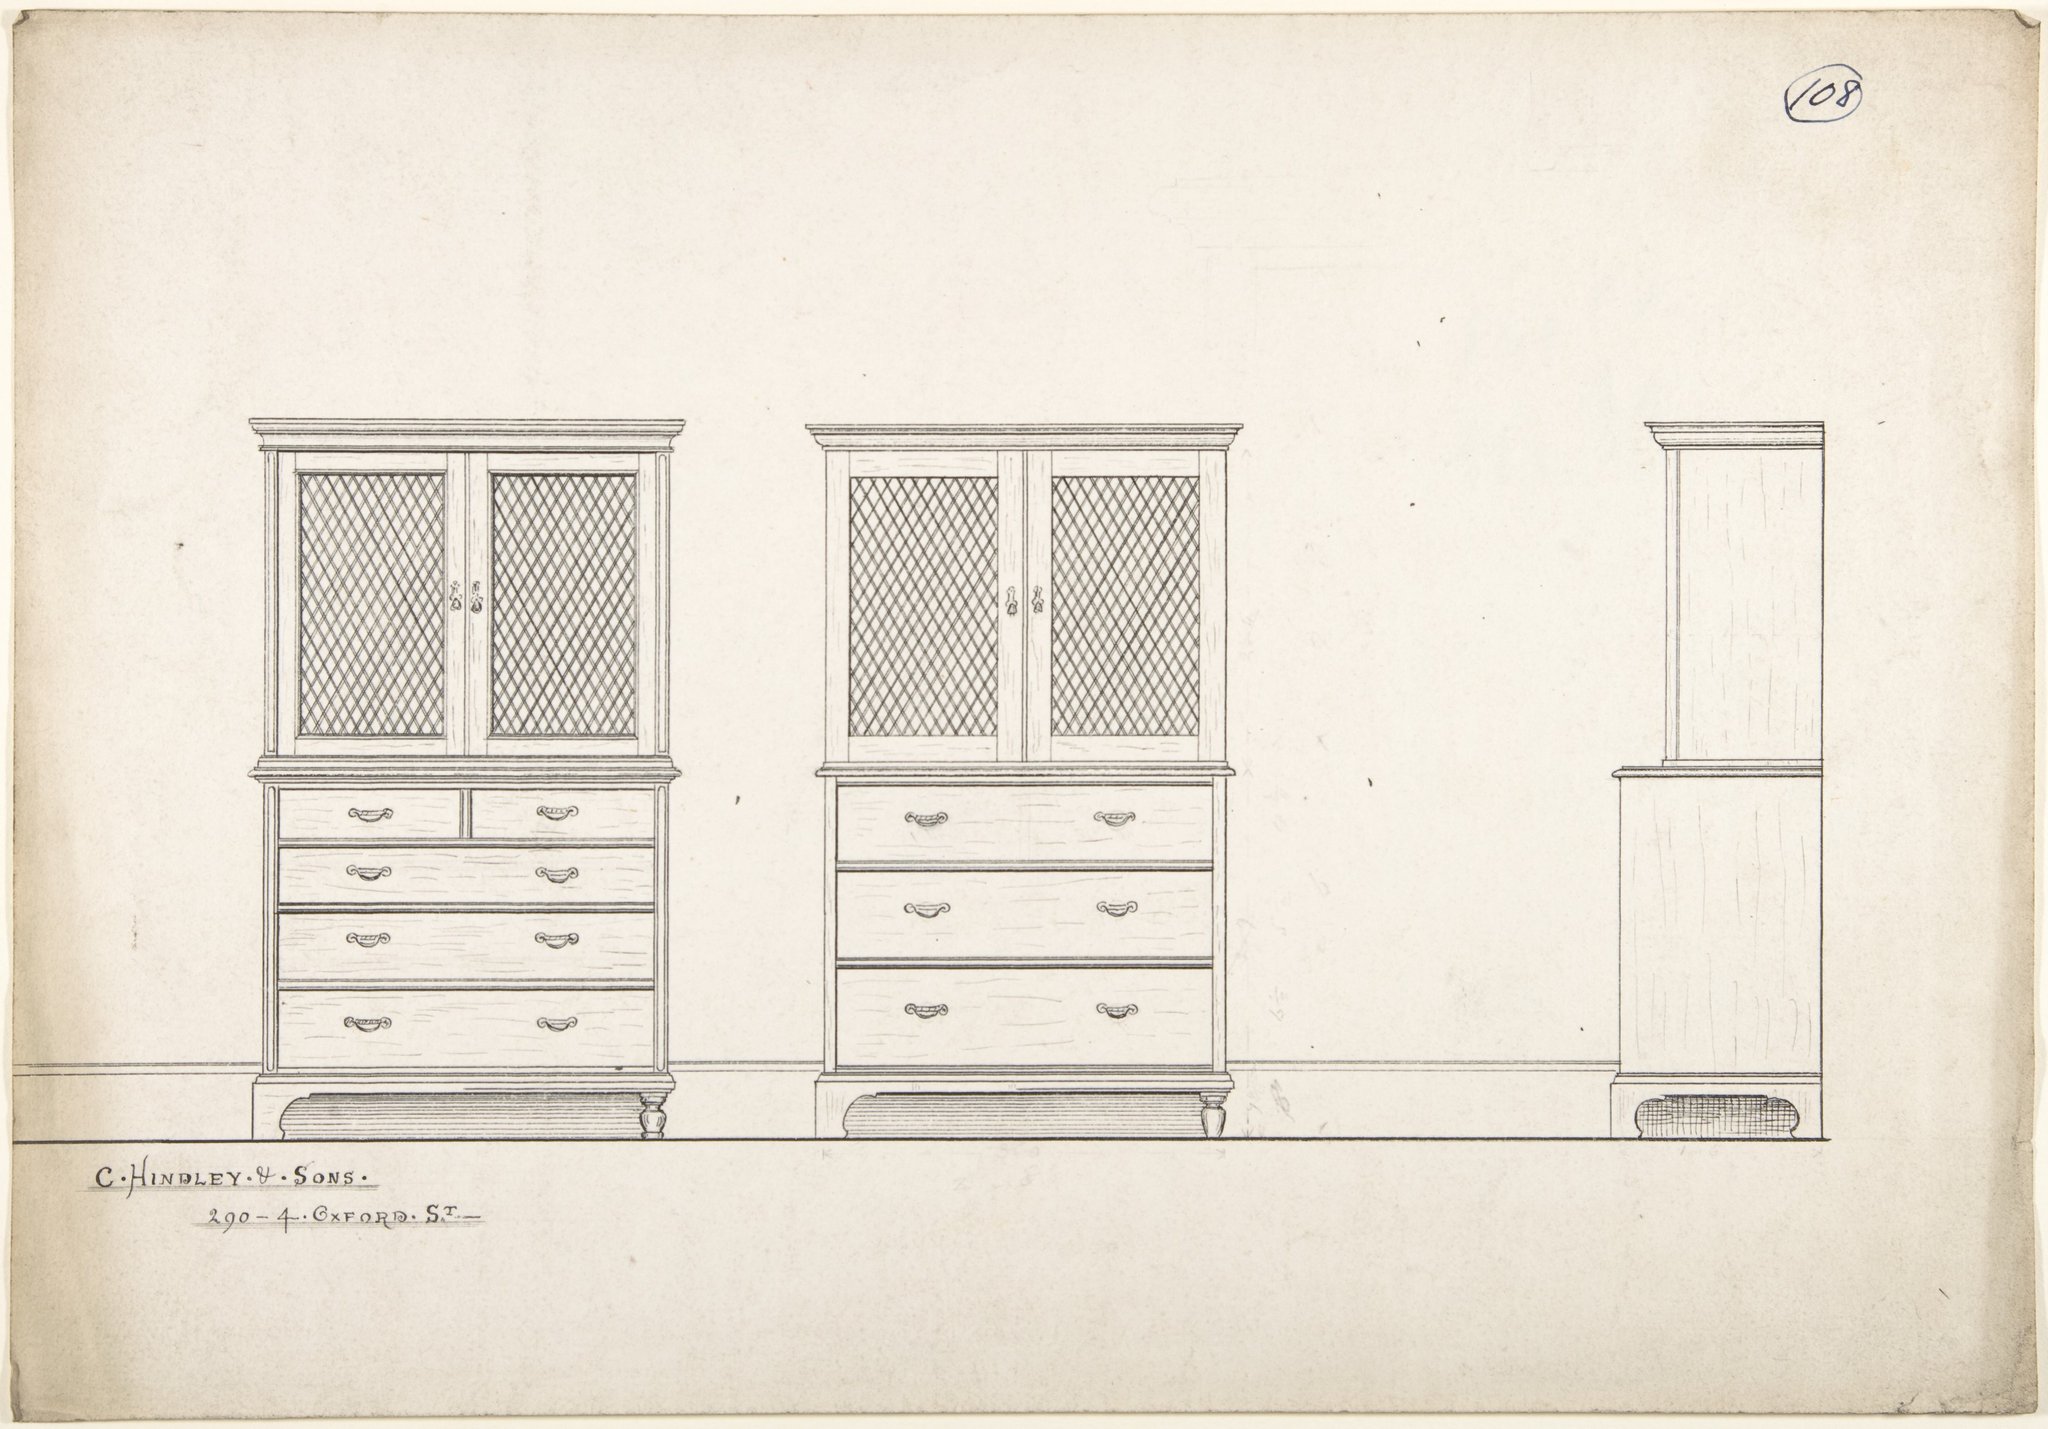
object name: drawing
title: Front and Side Views of Breakfronts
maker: charles hindley and sons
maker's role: artist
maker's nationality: british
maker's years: 1841-1917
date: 1841-1884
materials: ink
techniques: pen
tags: furniture